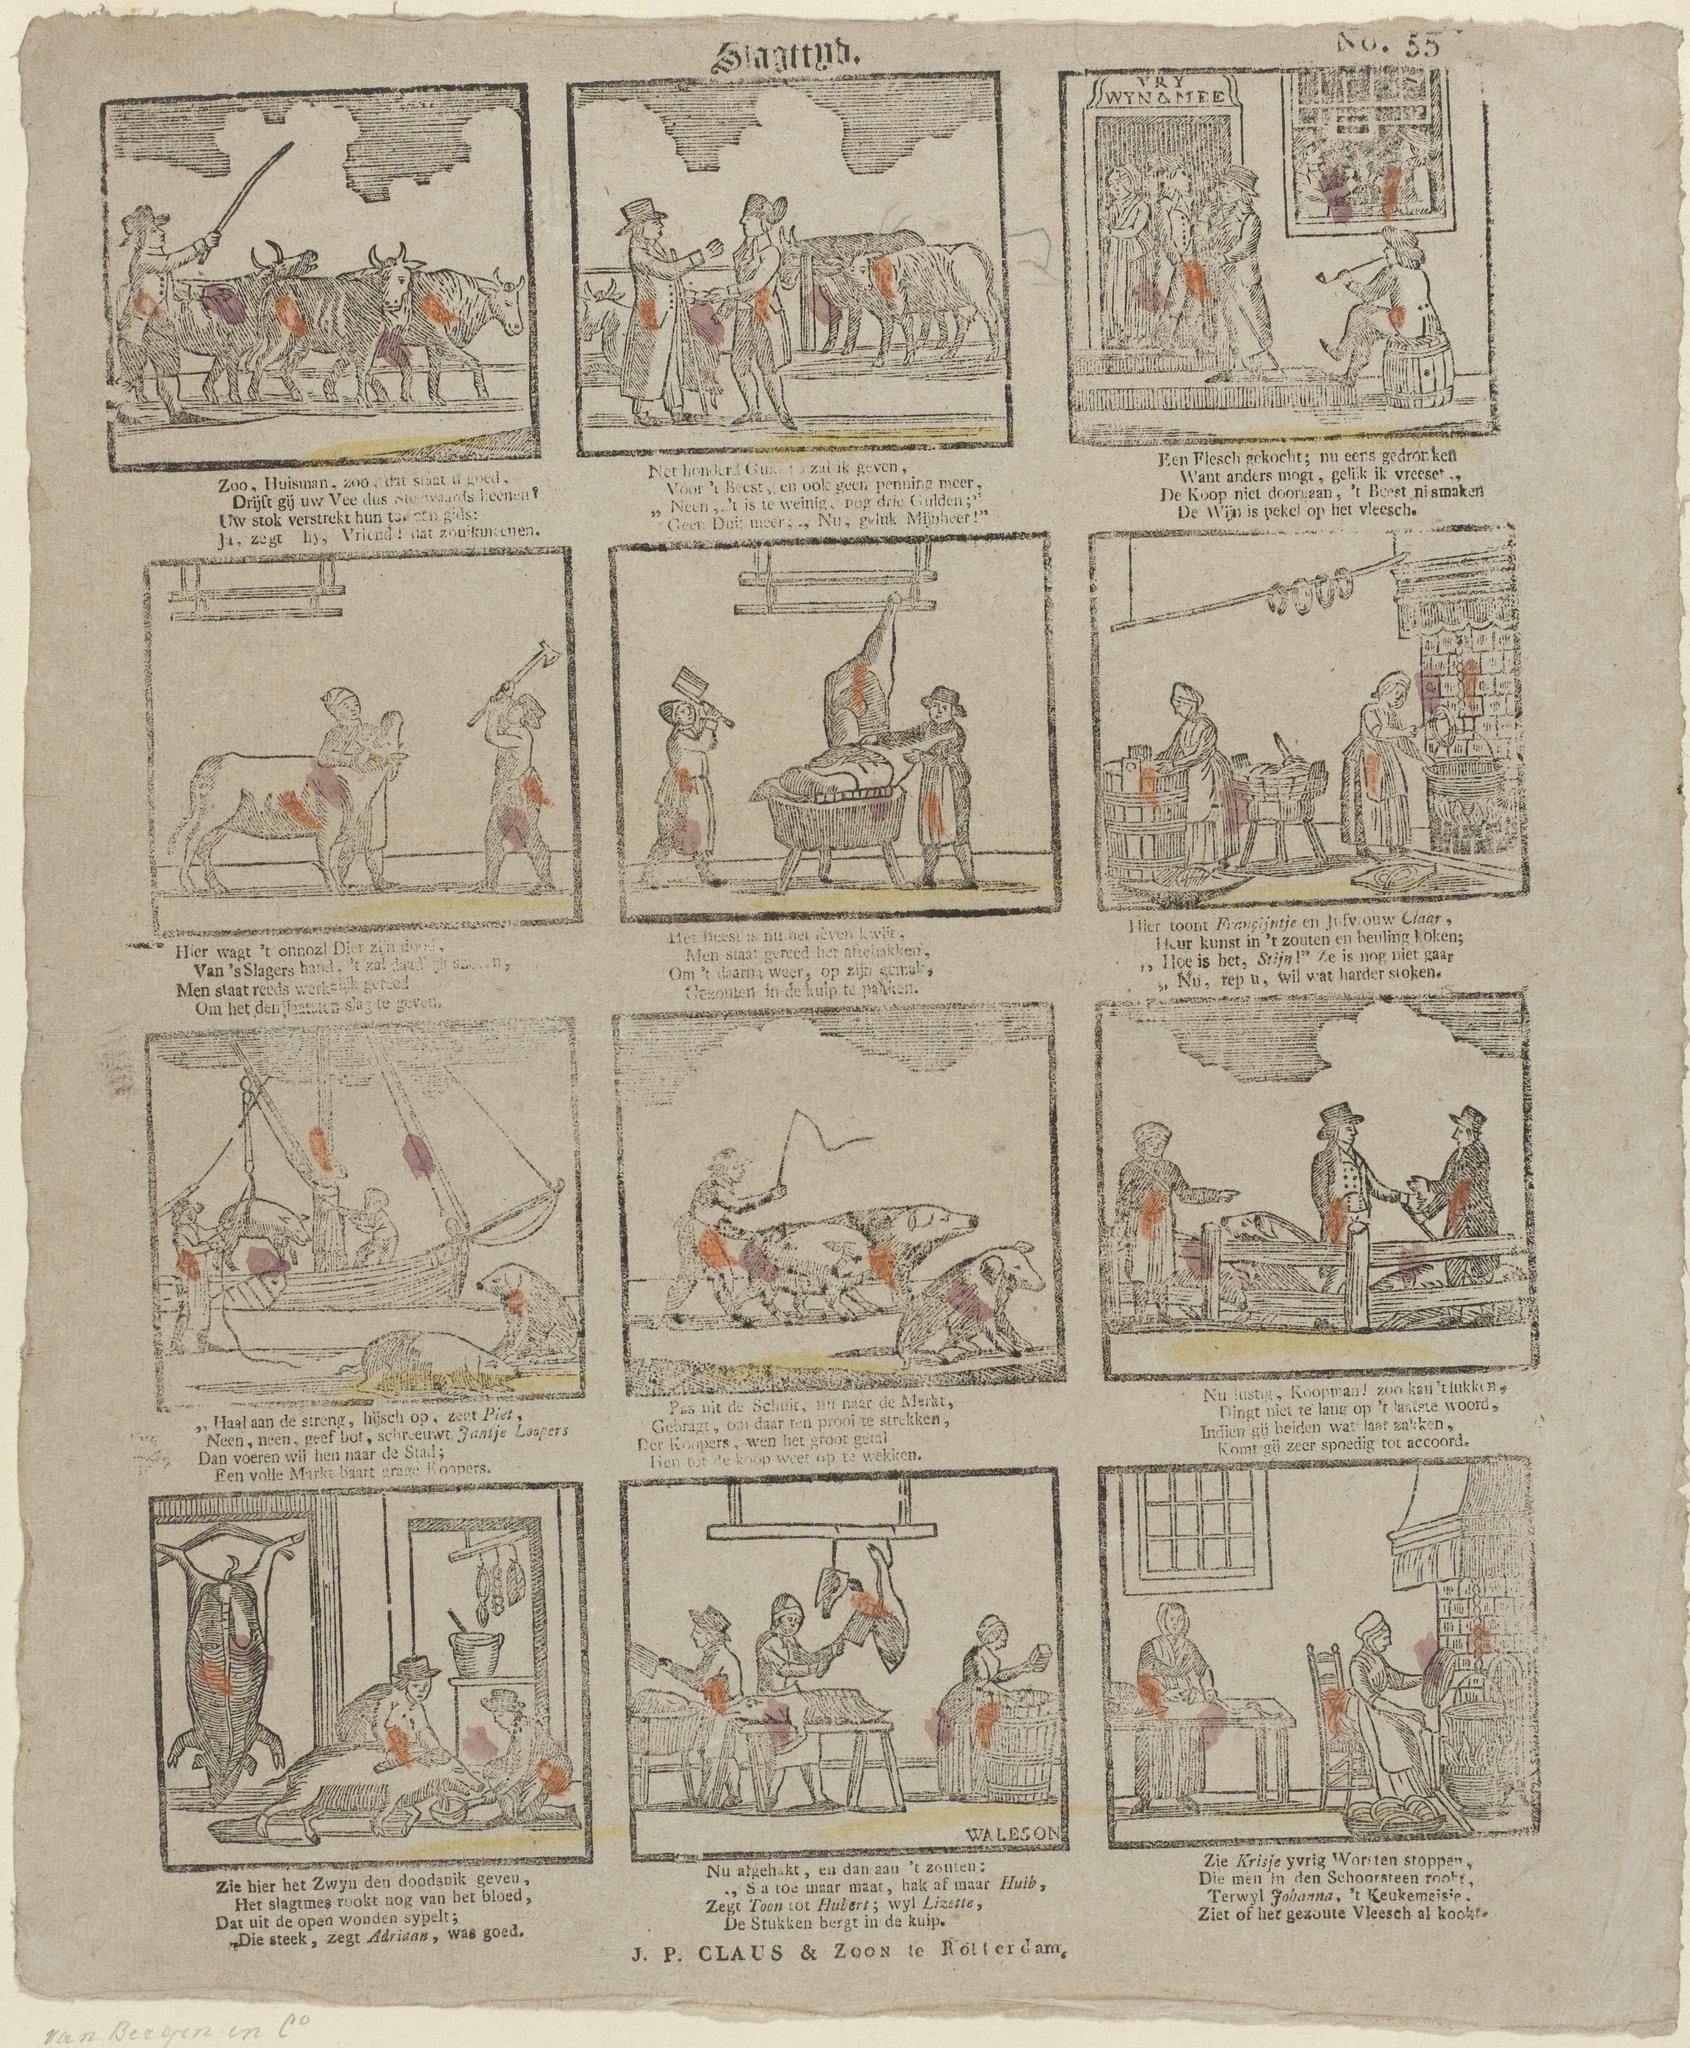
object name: popular print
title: Slagttyd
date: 1862-1905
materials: paper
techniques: colour, letterpress printing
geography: breda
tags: slaughtered ox or pig, butcher, slaughterman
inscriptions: collector's mark: Lugt 2760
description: Blad met 12 voorstellingen van het fokken, slachten en bereiden van koeien en varkens. Onder elke afbeelding een vierregelig vers. Genummerd rechtsboven: No. 55.